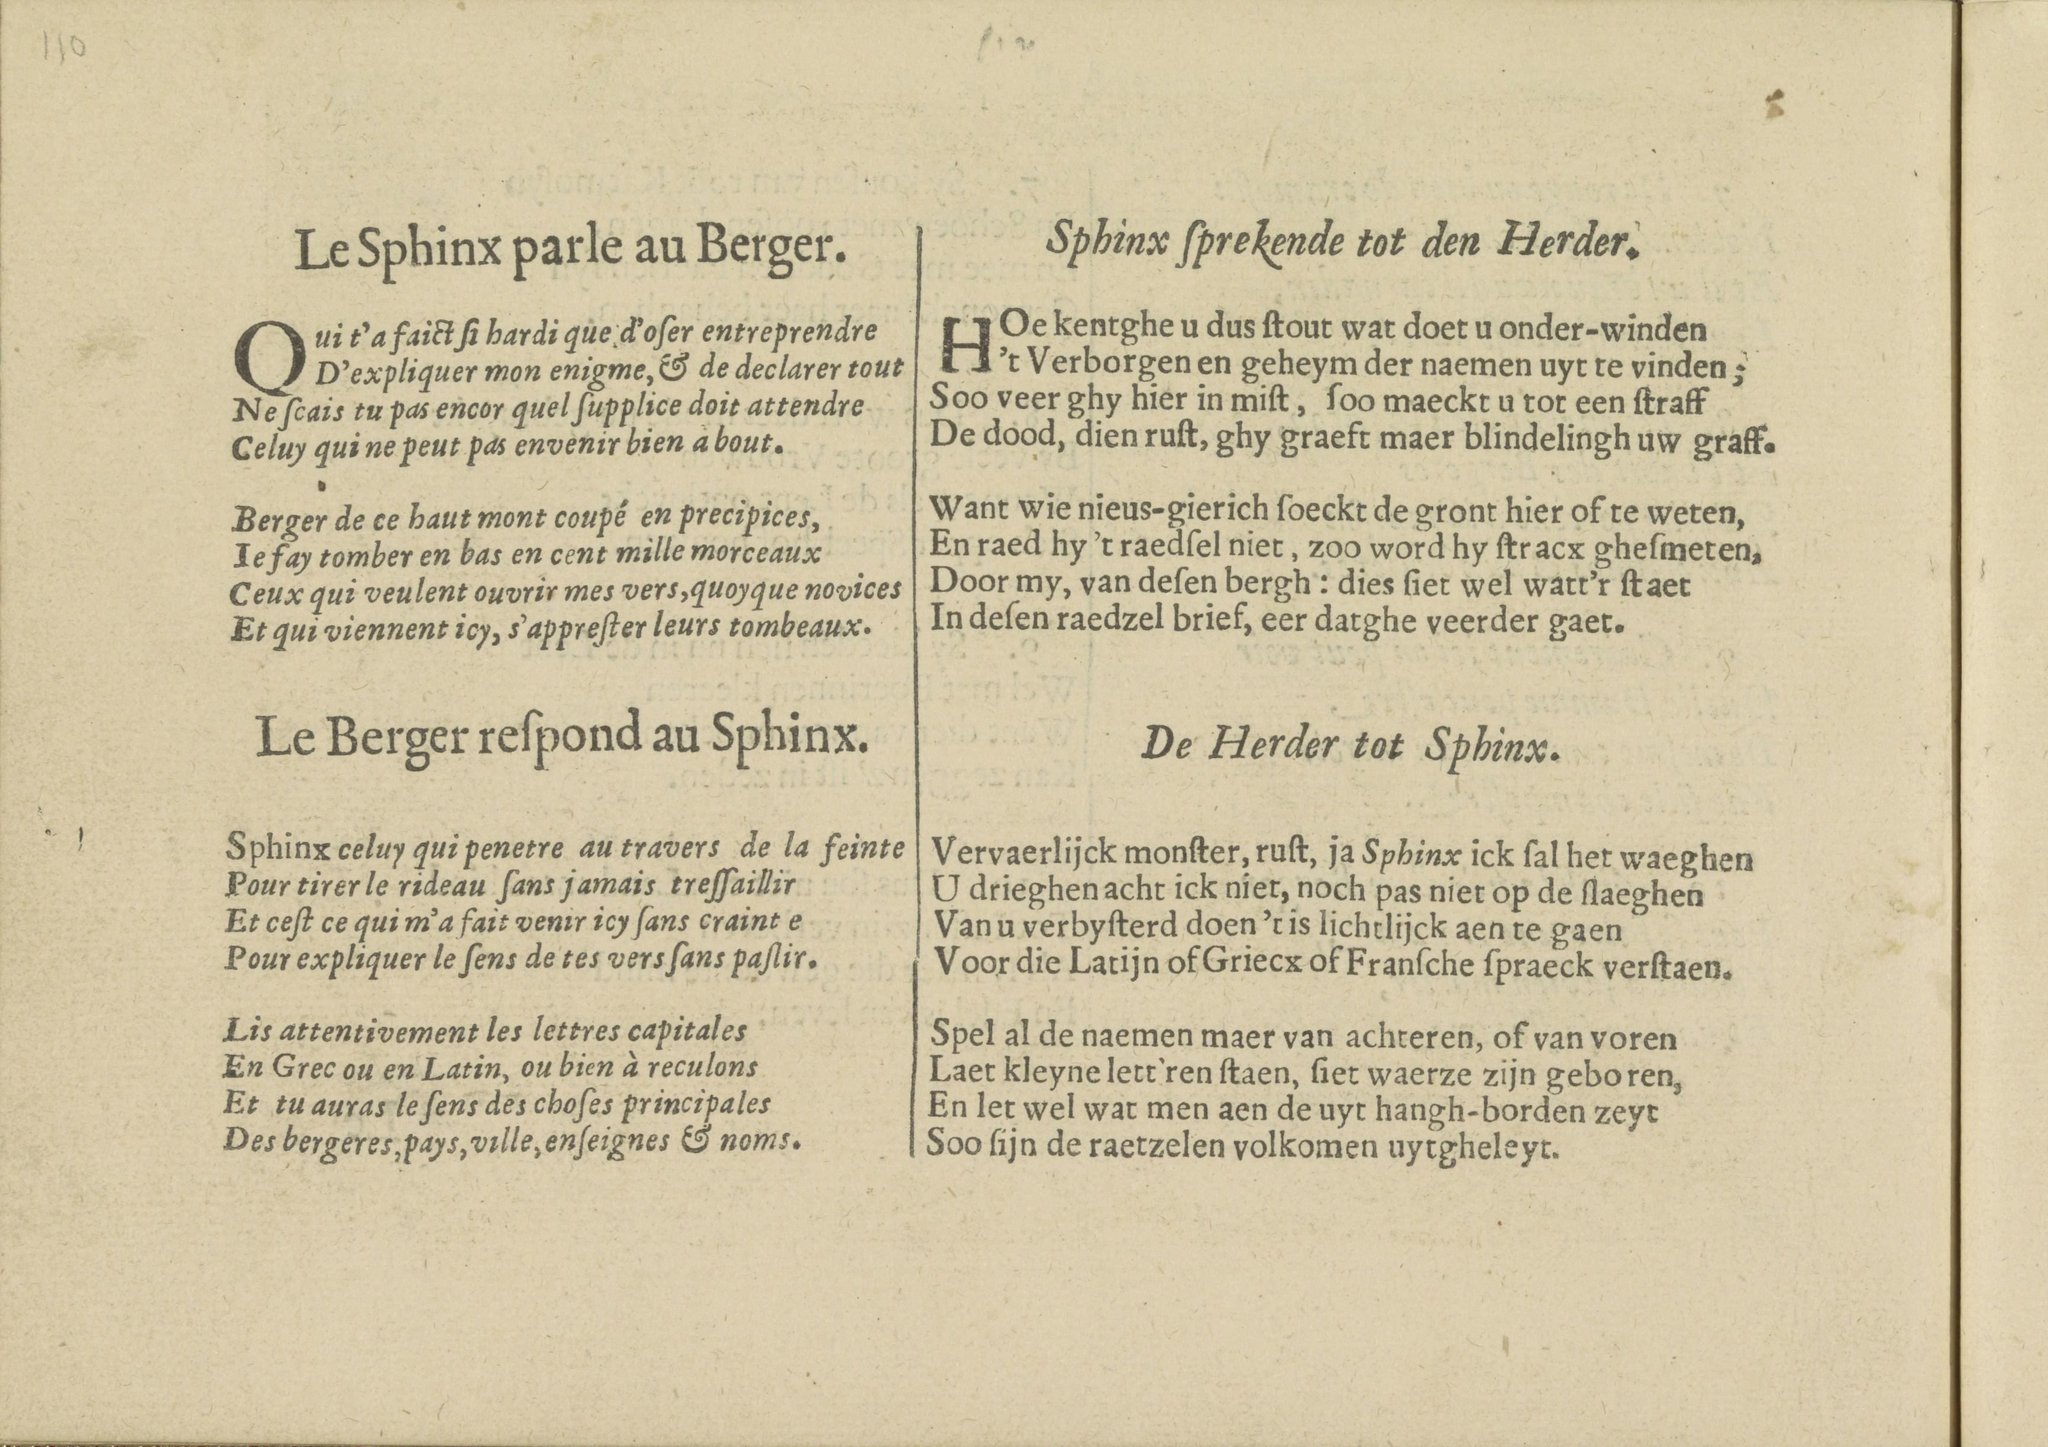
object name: album leaf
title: Les vrais pourtraits de quelques unes des plus grandes dames de la chrestiente desguisees en bergeres.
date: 1640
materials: paper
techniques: letterpress printing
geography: amsterdam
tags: initial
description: Dialoog bij een voorstelling van een sfinx en een herder, in twee keer vier kwatrijnen in het Frans en Nederlands. Het blad maakt deel uit van een album.